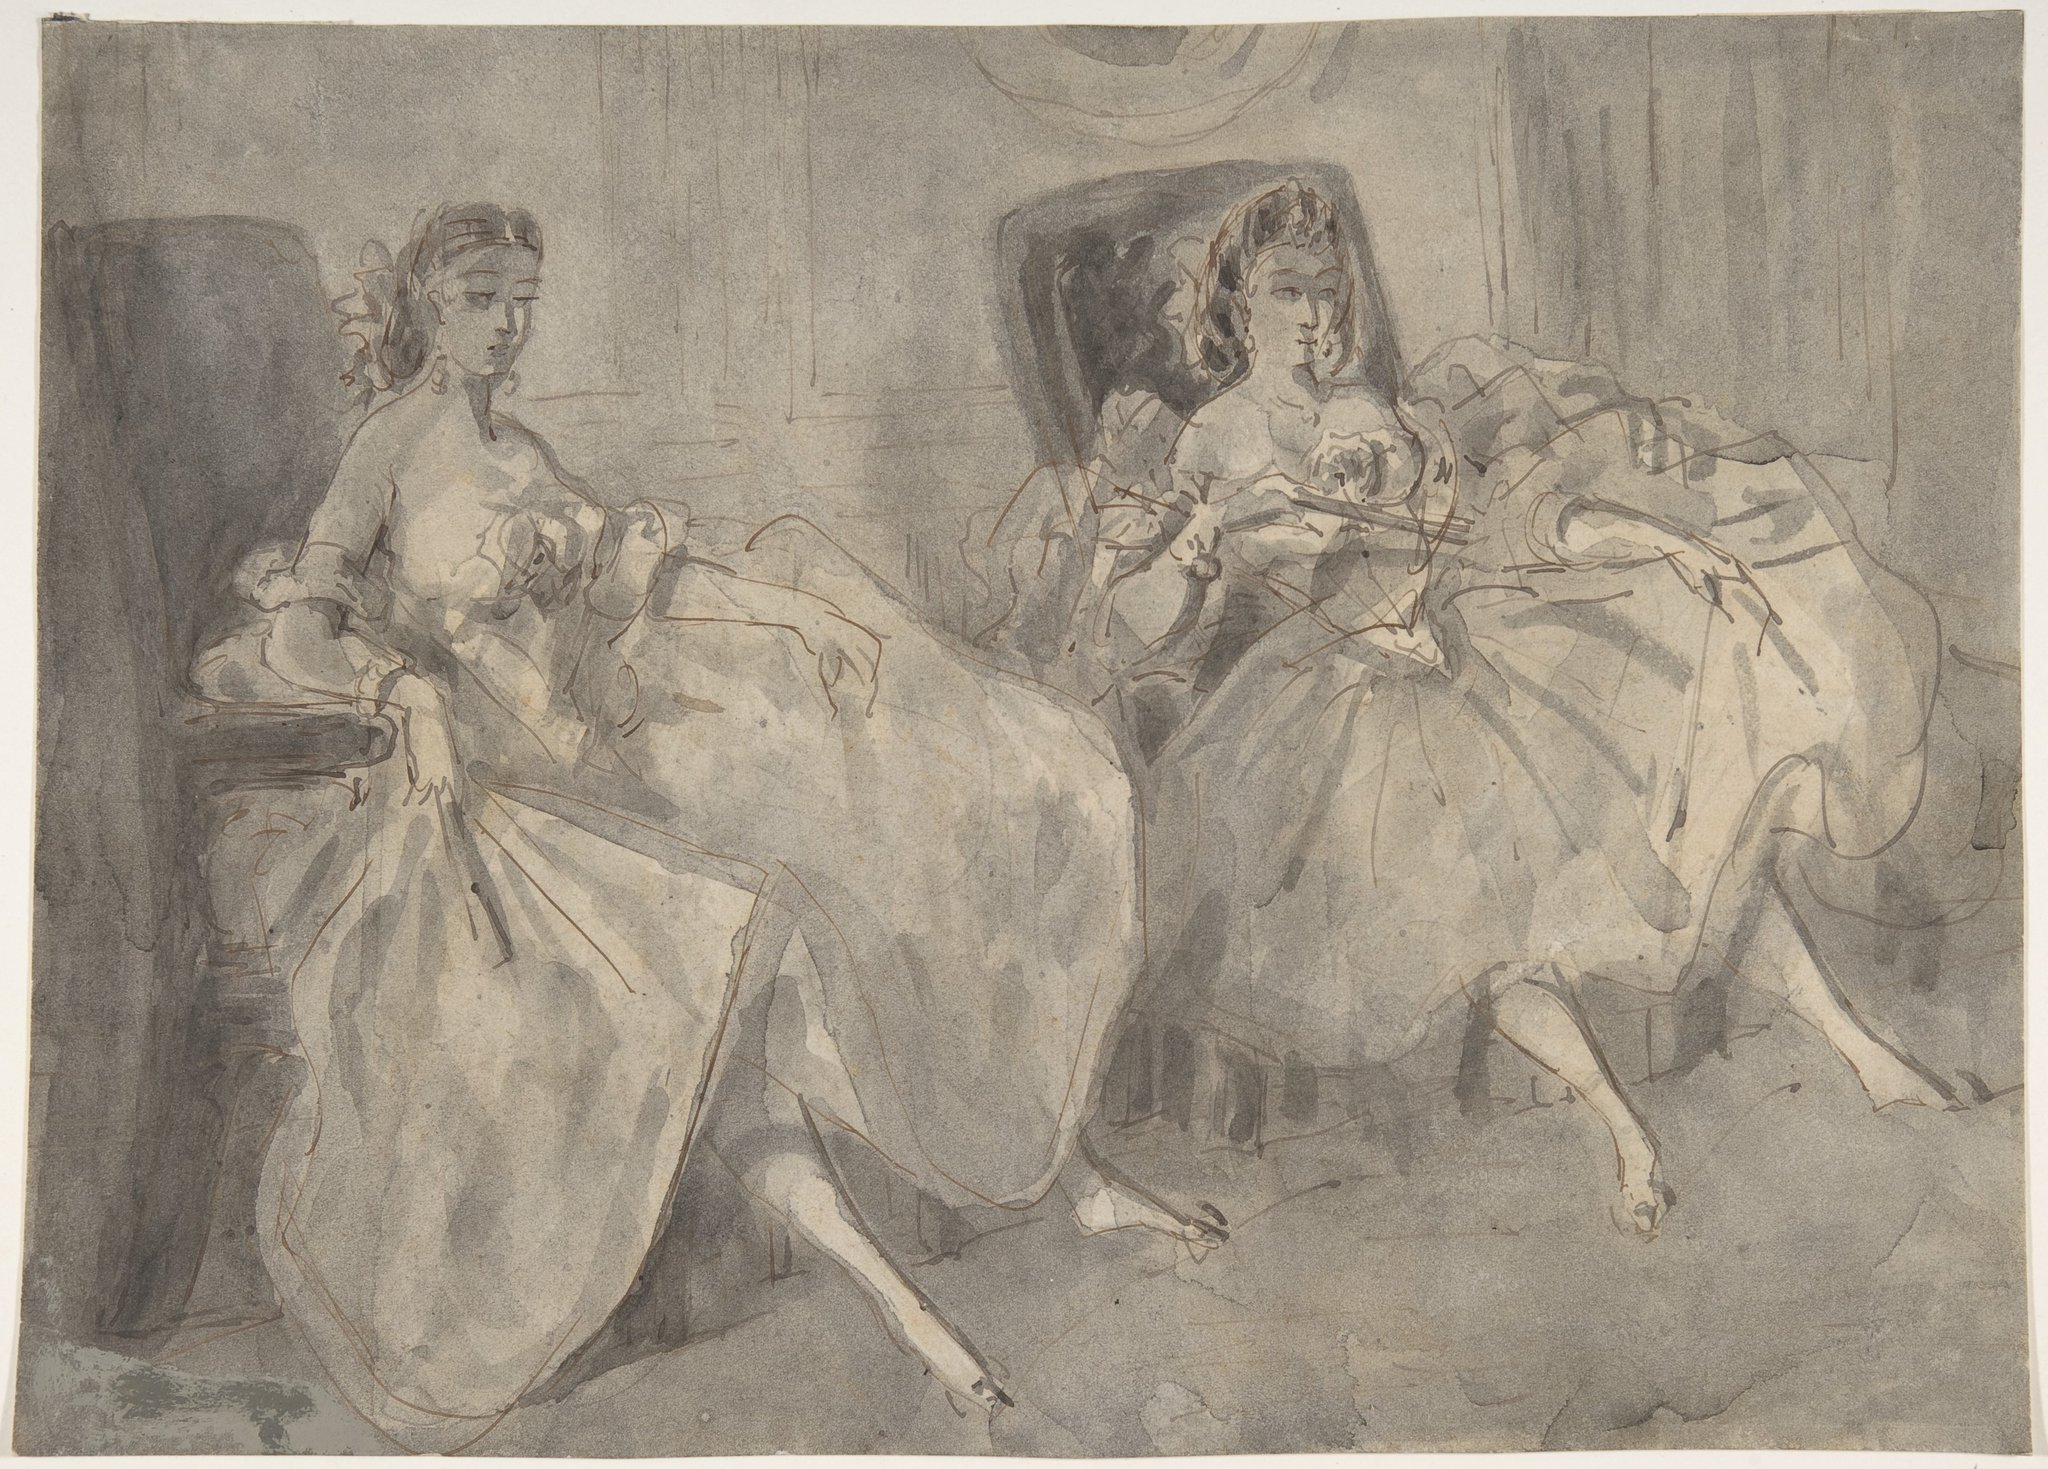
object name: drawing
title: Two Seated Women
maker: constantin guys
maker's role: artist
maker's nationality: french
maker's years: 1802-1892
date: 1801-1900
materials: graphite, ink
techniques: pen, wash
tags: women